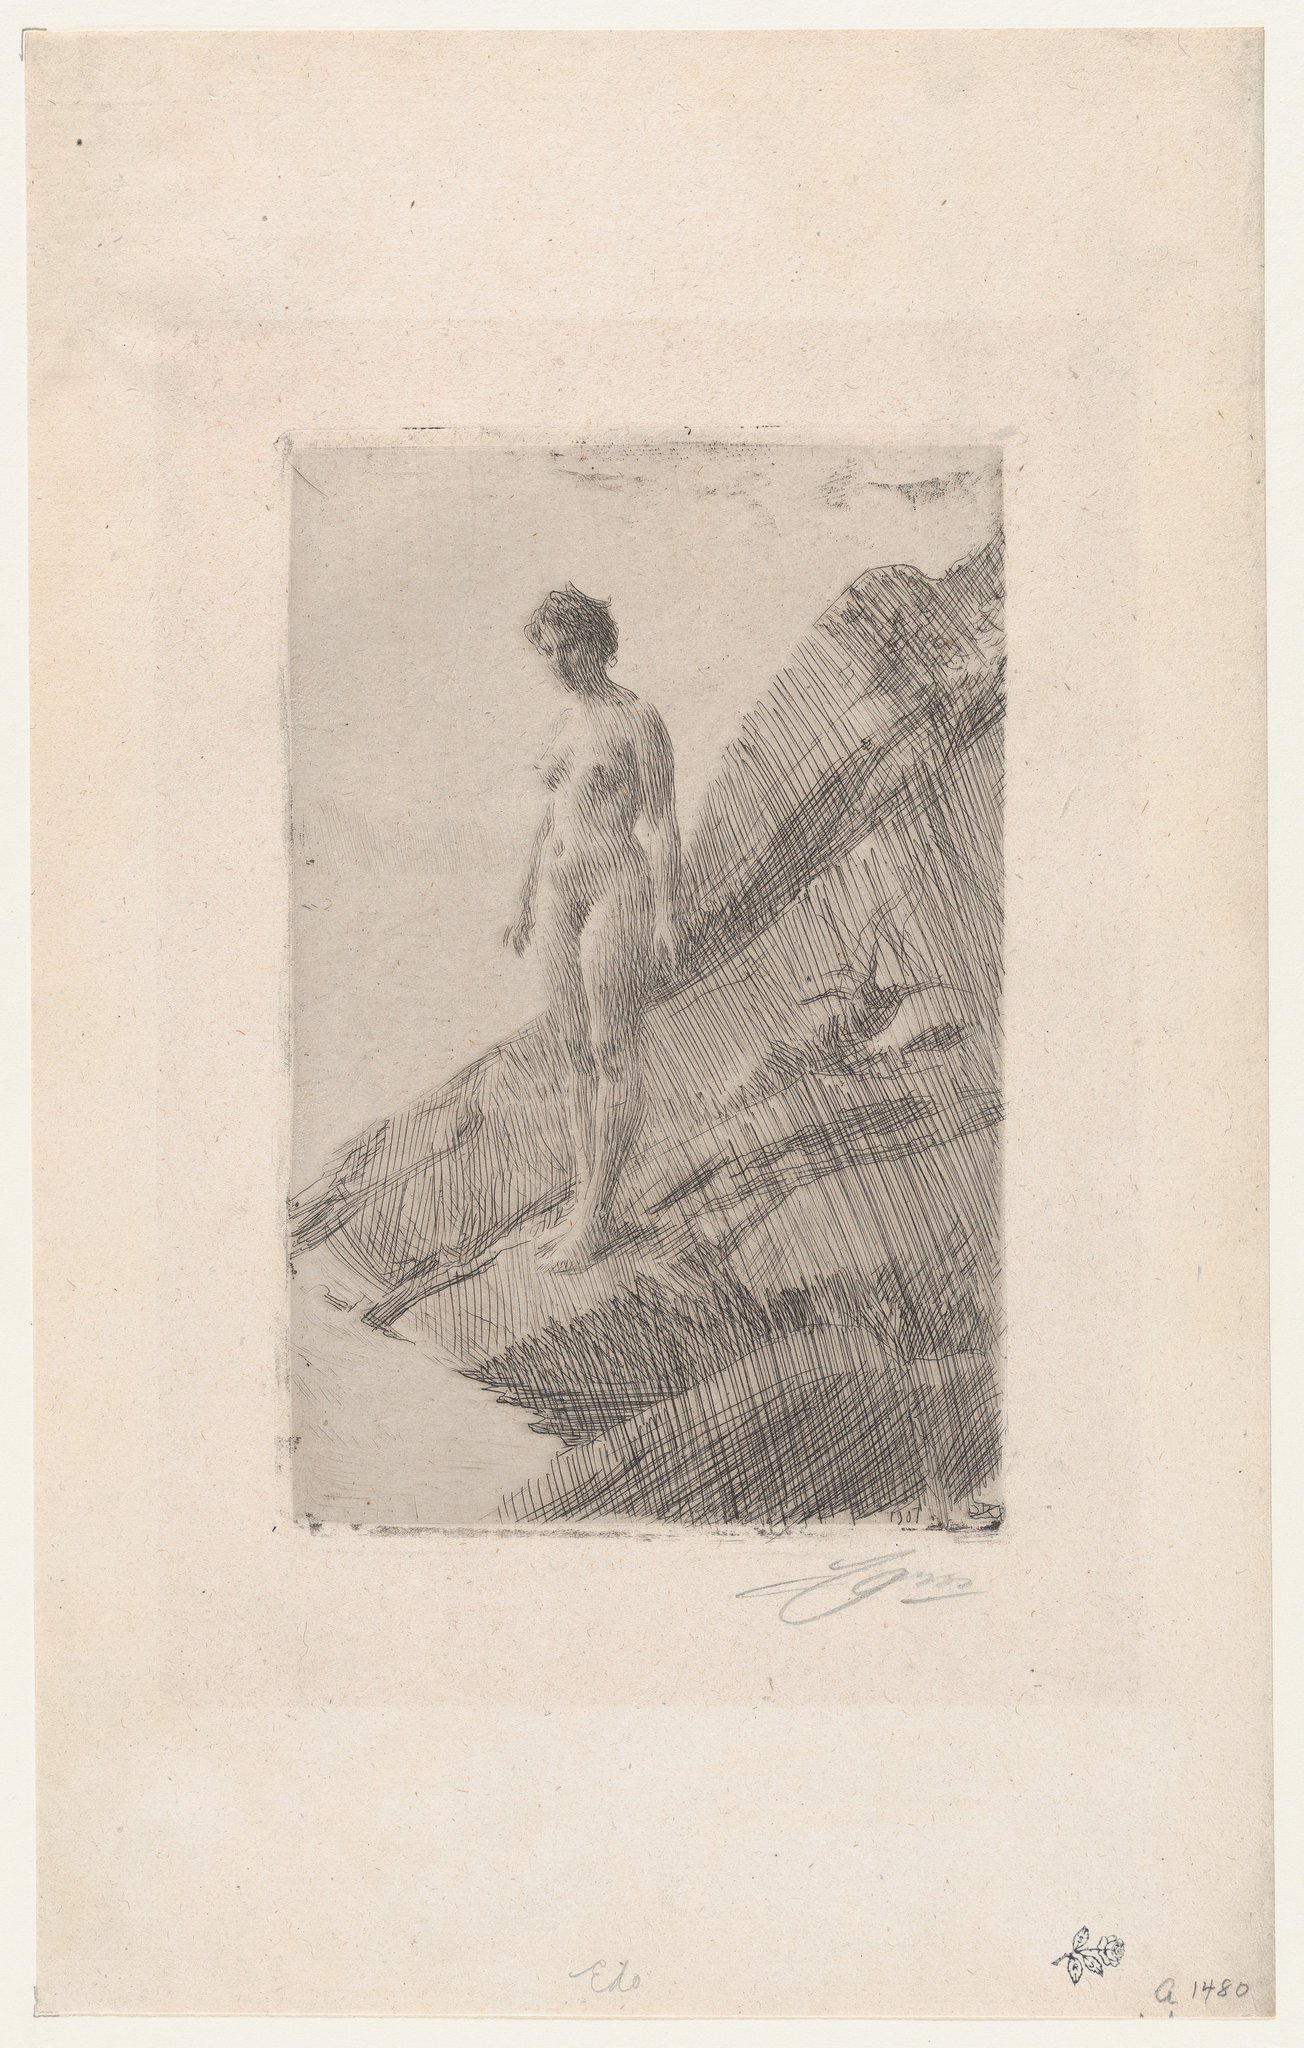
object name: print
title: Edö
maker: anders zorn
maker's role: artist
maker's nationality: swedish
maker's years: 1860-1920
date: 1907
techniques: etching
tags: female nudes